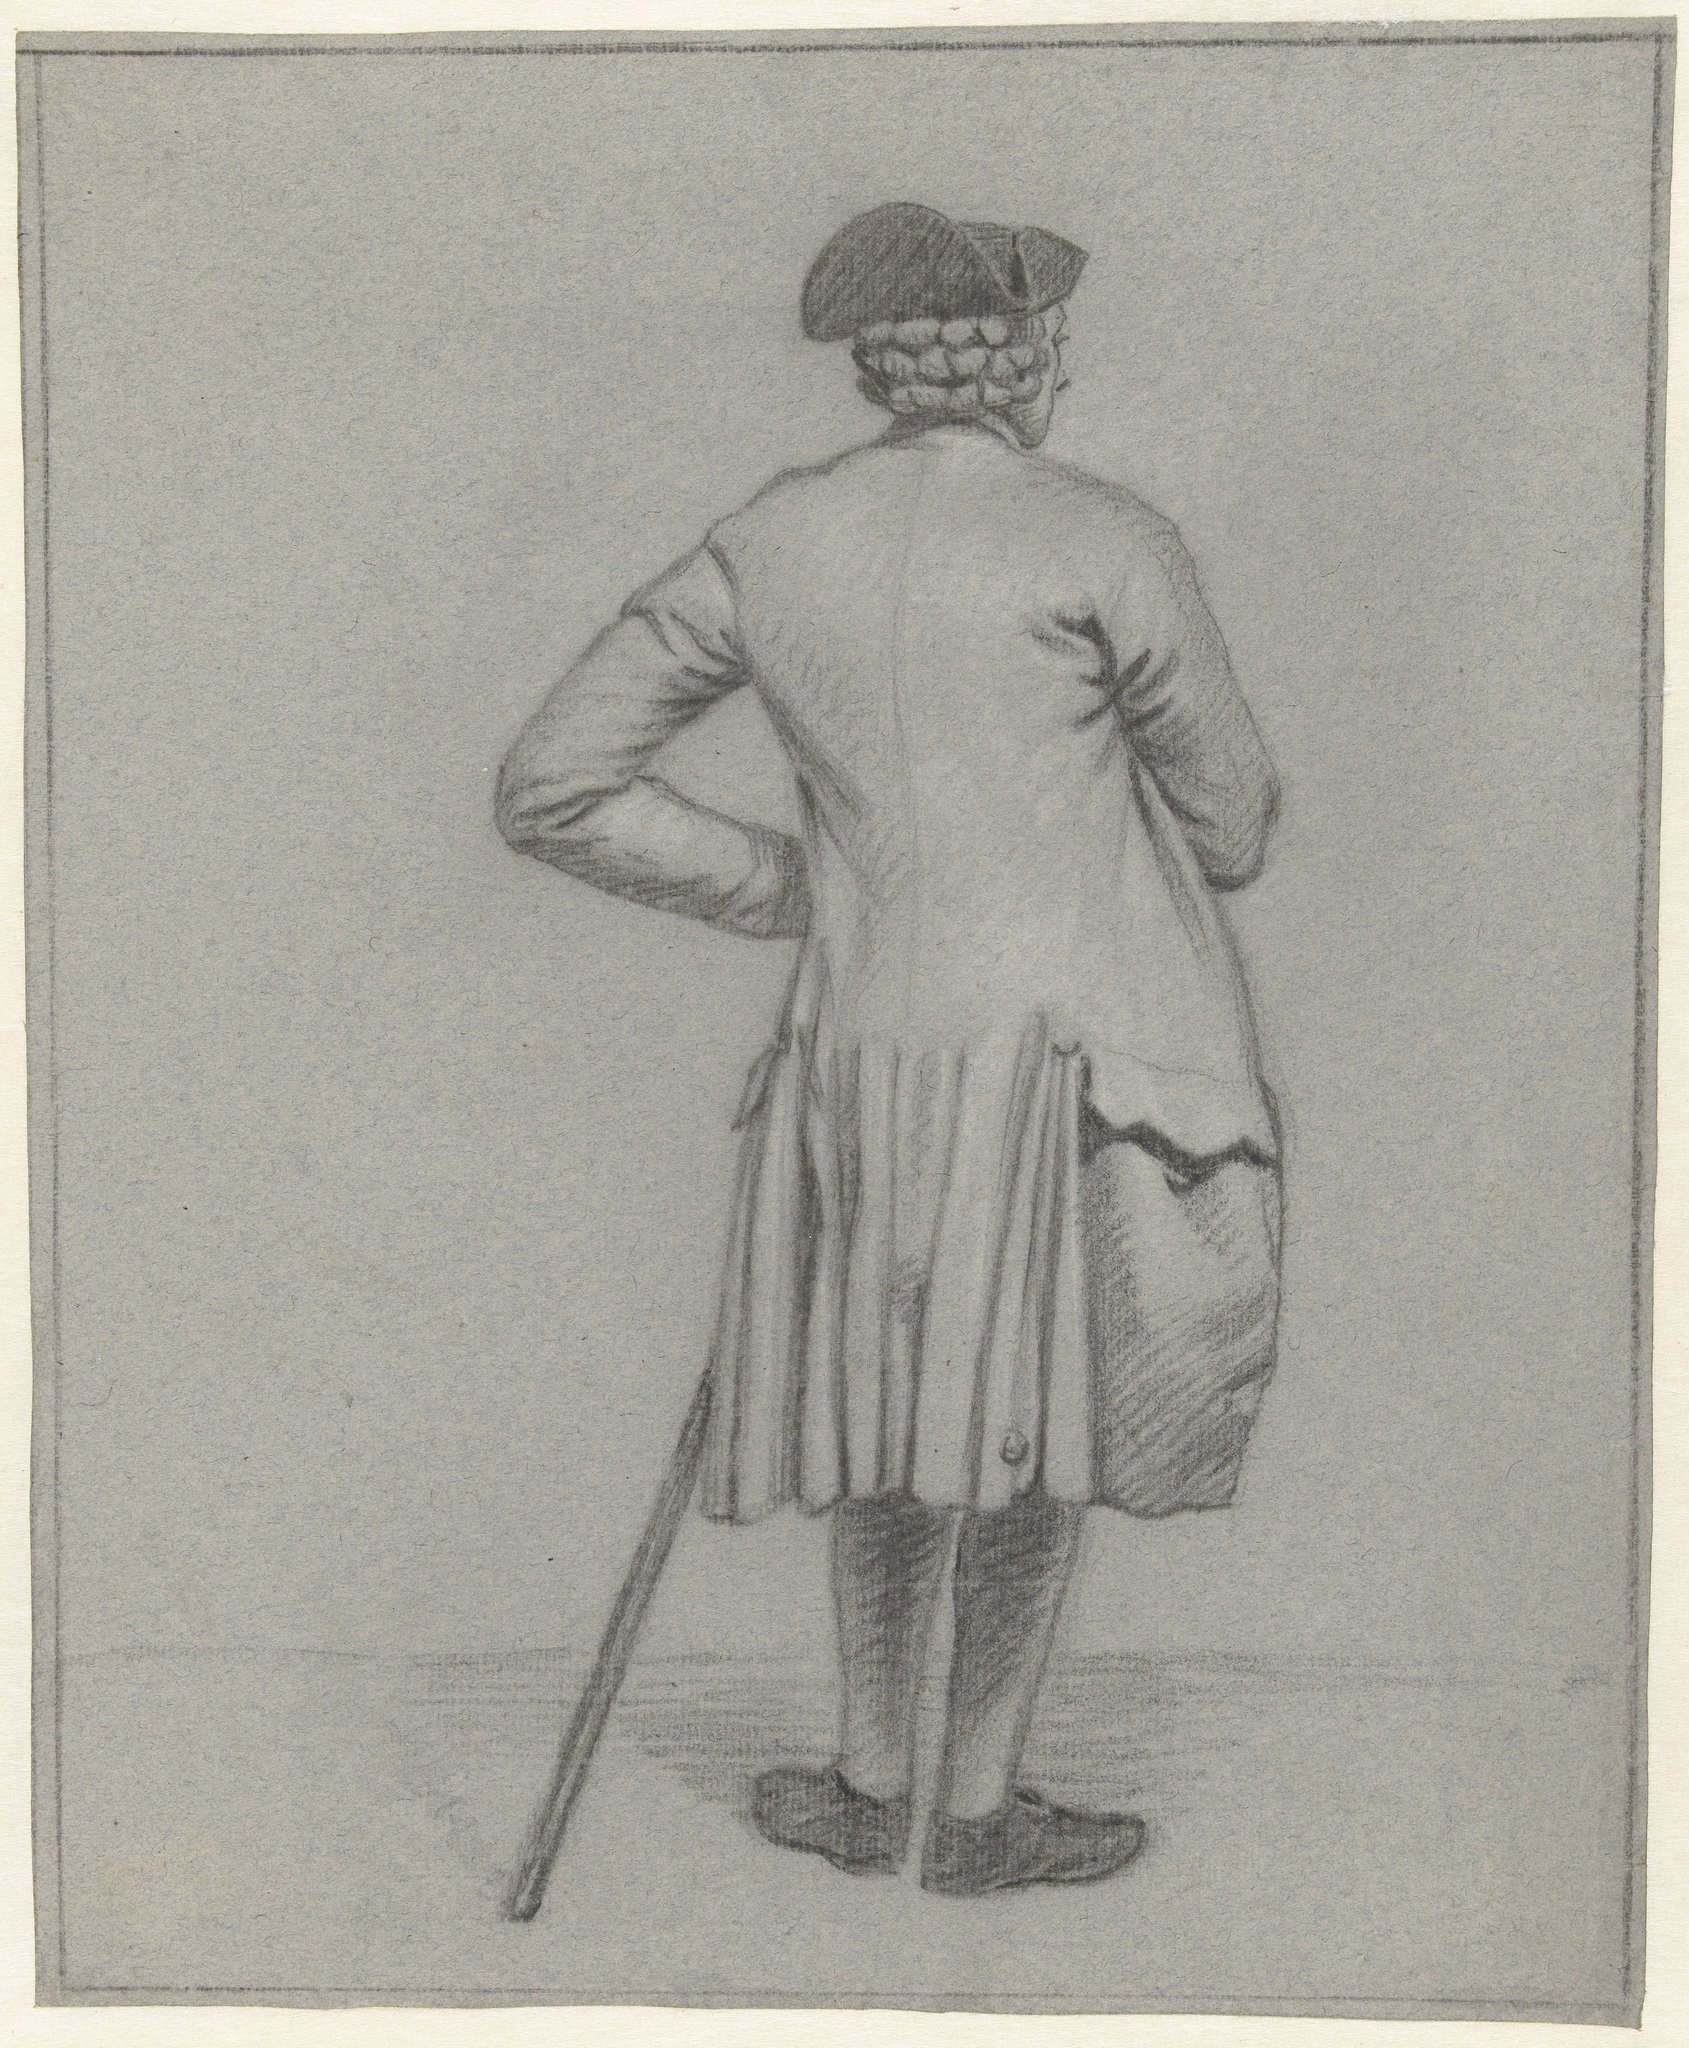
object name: drawing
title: Staande man, op de rug gezien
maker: jordanus hoorn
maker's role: draughtsman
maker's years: 1753-1833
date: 1763-1833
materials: chalk, paper